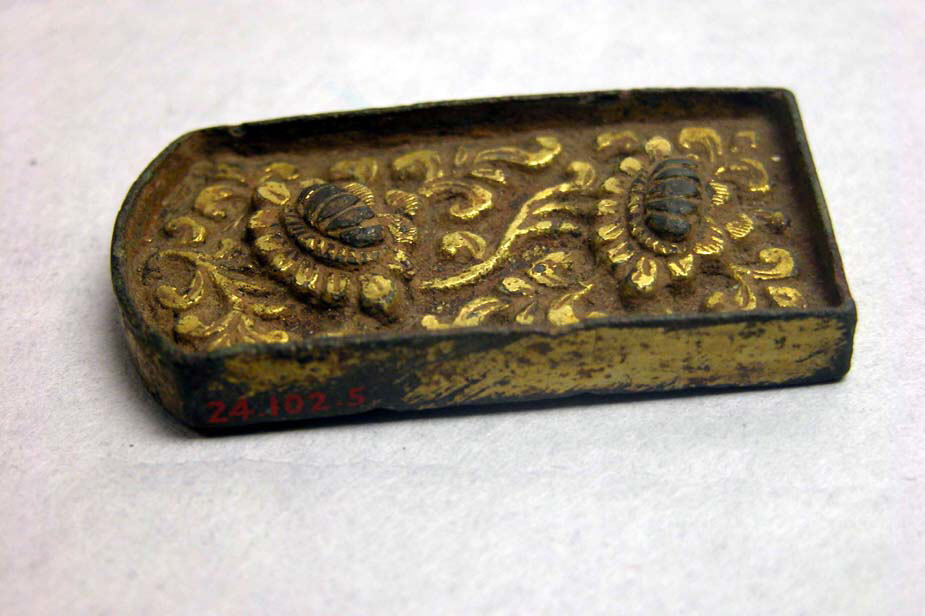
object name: belt plaque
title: Decorative belt plaque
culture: chinese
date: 618-907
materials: gilt bronze